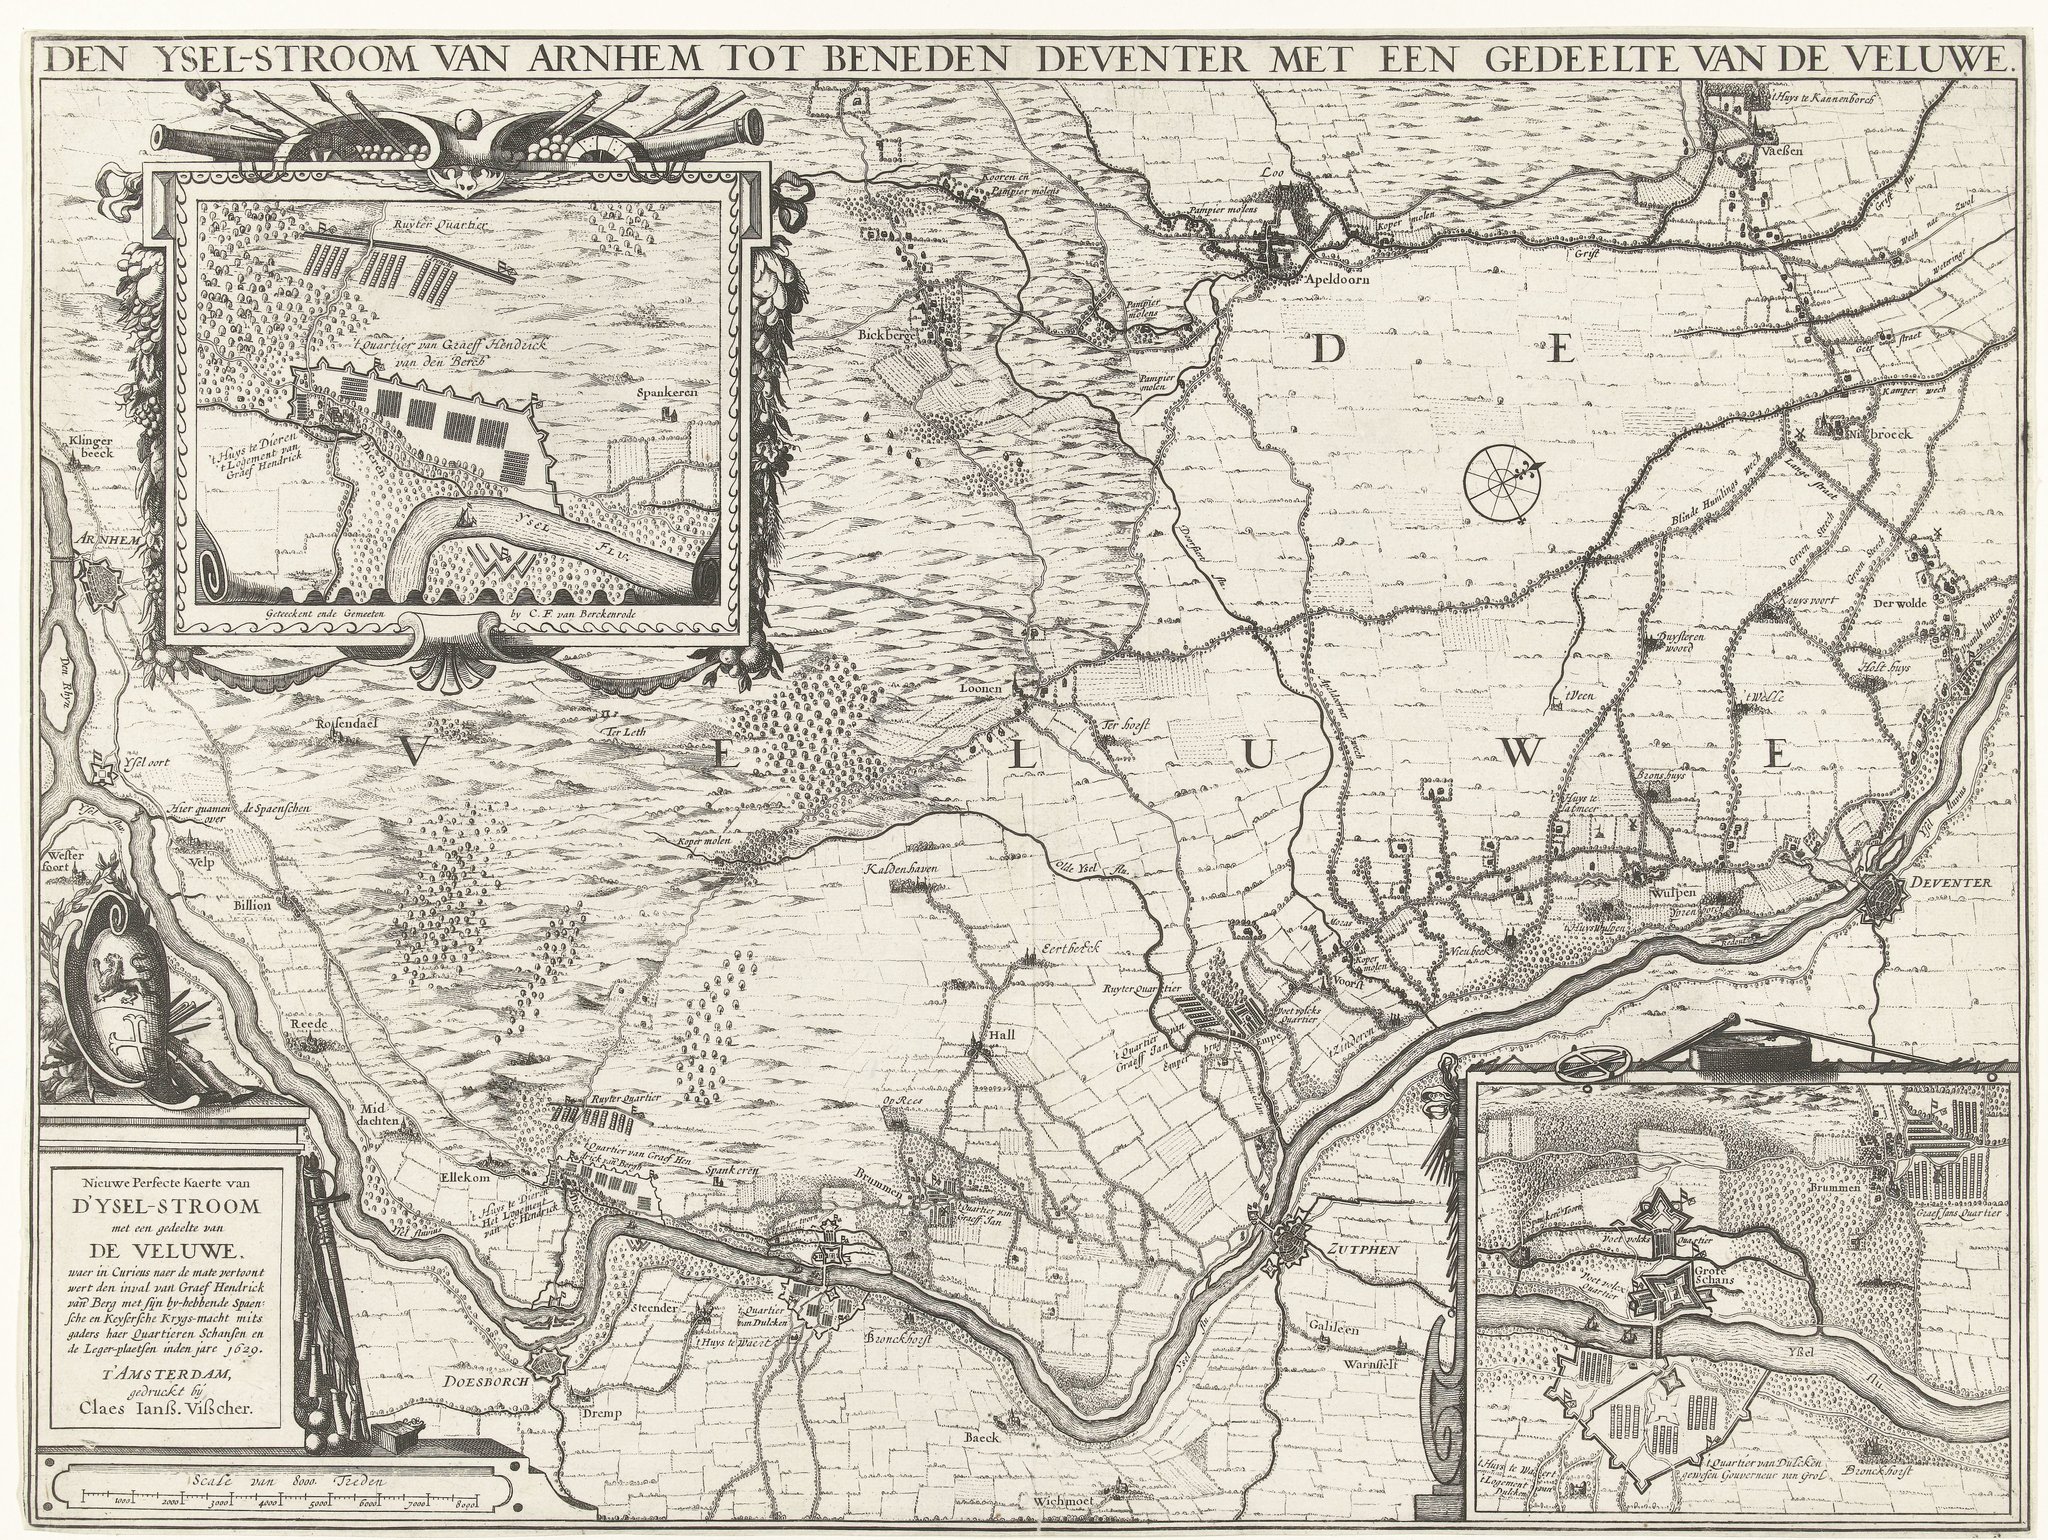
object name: map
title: Den Ysel-stroom van Arnhem to beneden Deventer met een gedeelte van de Veluwe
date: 1629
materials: paper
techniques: etching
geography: amsterdam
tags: earl, maps of separate countries or regions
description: Kaart van de loop van de IJssel door het gebied tussen Arnhem en Deventer met de inval van graaf Hendrik van den Bergh in de Veluwe, juli 1629. Met twee afzonderlijke kleine kaarten van de legerplaats van de graaf van den Bergh bij het Huis te Dieren en het kwartier bij Brummen van Dulcken, gouverneur van Grol.